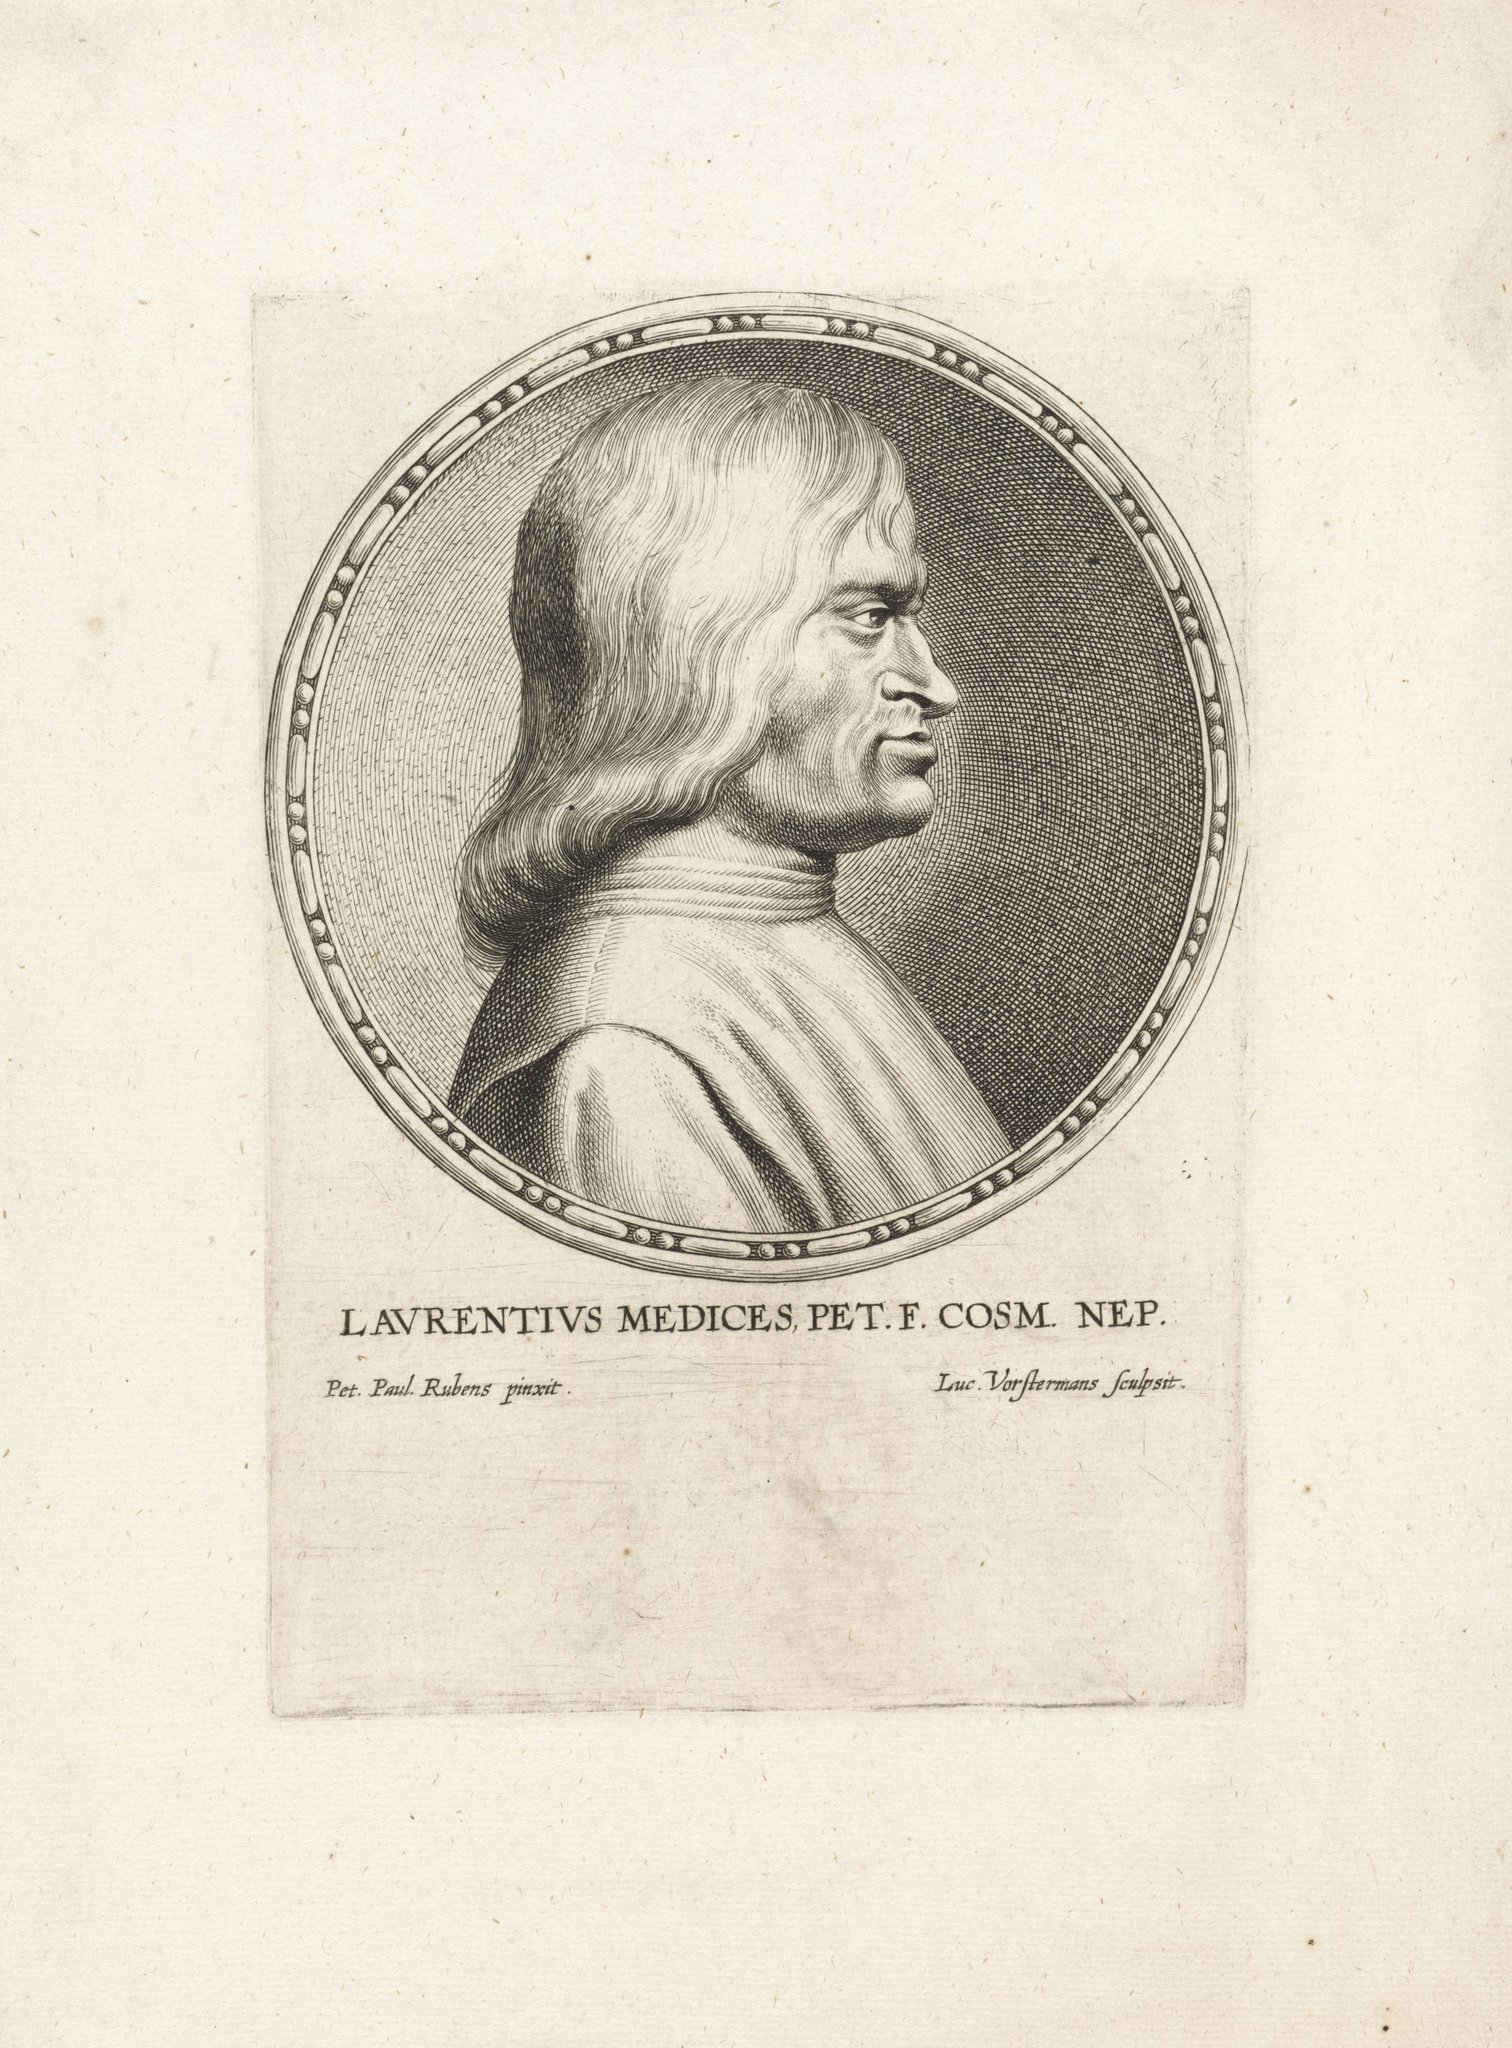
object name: print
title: Portret van Lorenzo de' Medici (I)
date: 1619-1675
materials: paper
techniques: engraving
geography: antwerp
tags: florence, careggi, schrijver, lorenzo de' medici (i)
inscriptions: collector's mark: Lugt 240